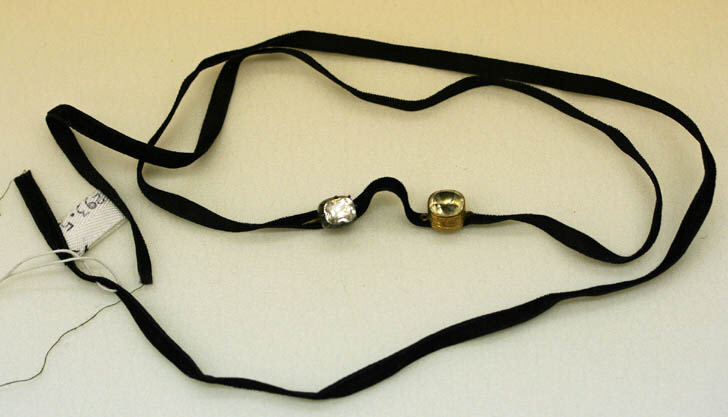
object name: ribbon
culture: american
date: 1801-1900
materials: glass, metal, silk